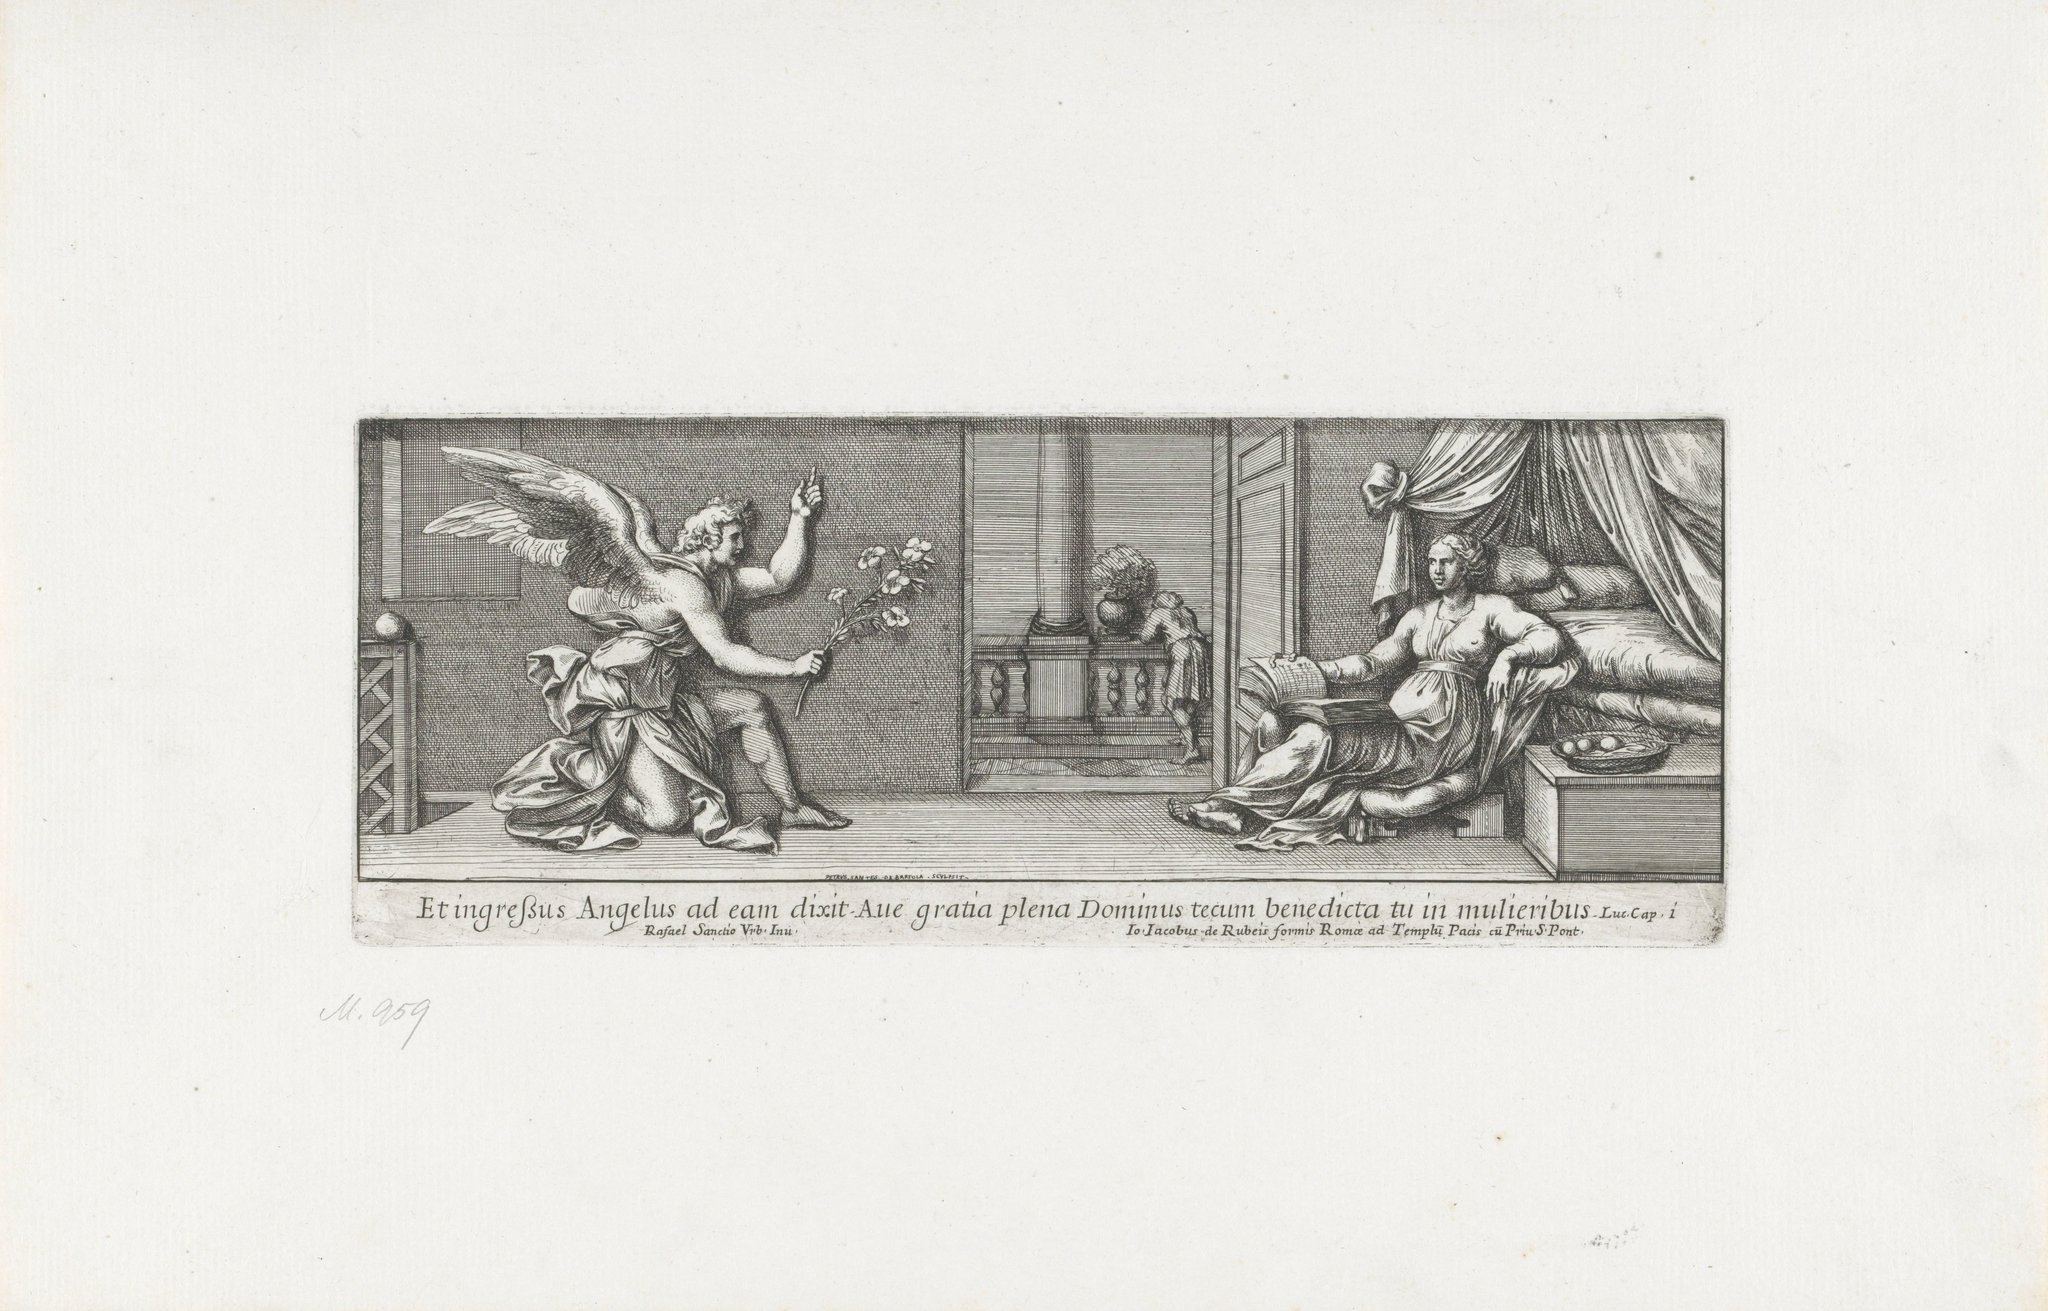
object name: print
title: Annunciatie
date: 1645-1700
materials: paper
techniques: engraving, etching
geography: vatican city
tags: the annunciation: mary, usually reading, is visited by the angel (sometimes a woman overhears the conversation)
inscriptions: collector's mark: Lugt 2228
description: Prent uit een reeks van 14 prenten (+ titelprent) naar schilderingen door Rafaël in de Stanze di Raffaello in het Apostolisch Paleis in het Vaticaan en naar ontwerpen voor wandtapijten voor de Sixtijnse Kapel door Rafaël. Mogelijk naar een schildering door Rafaël in de Stanza di Eliodoro.